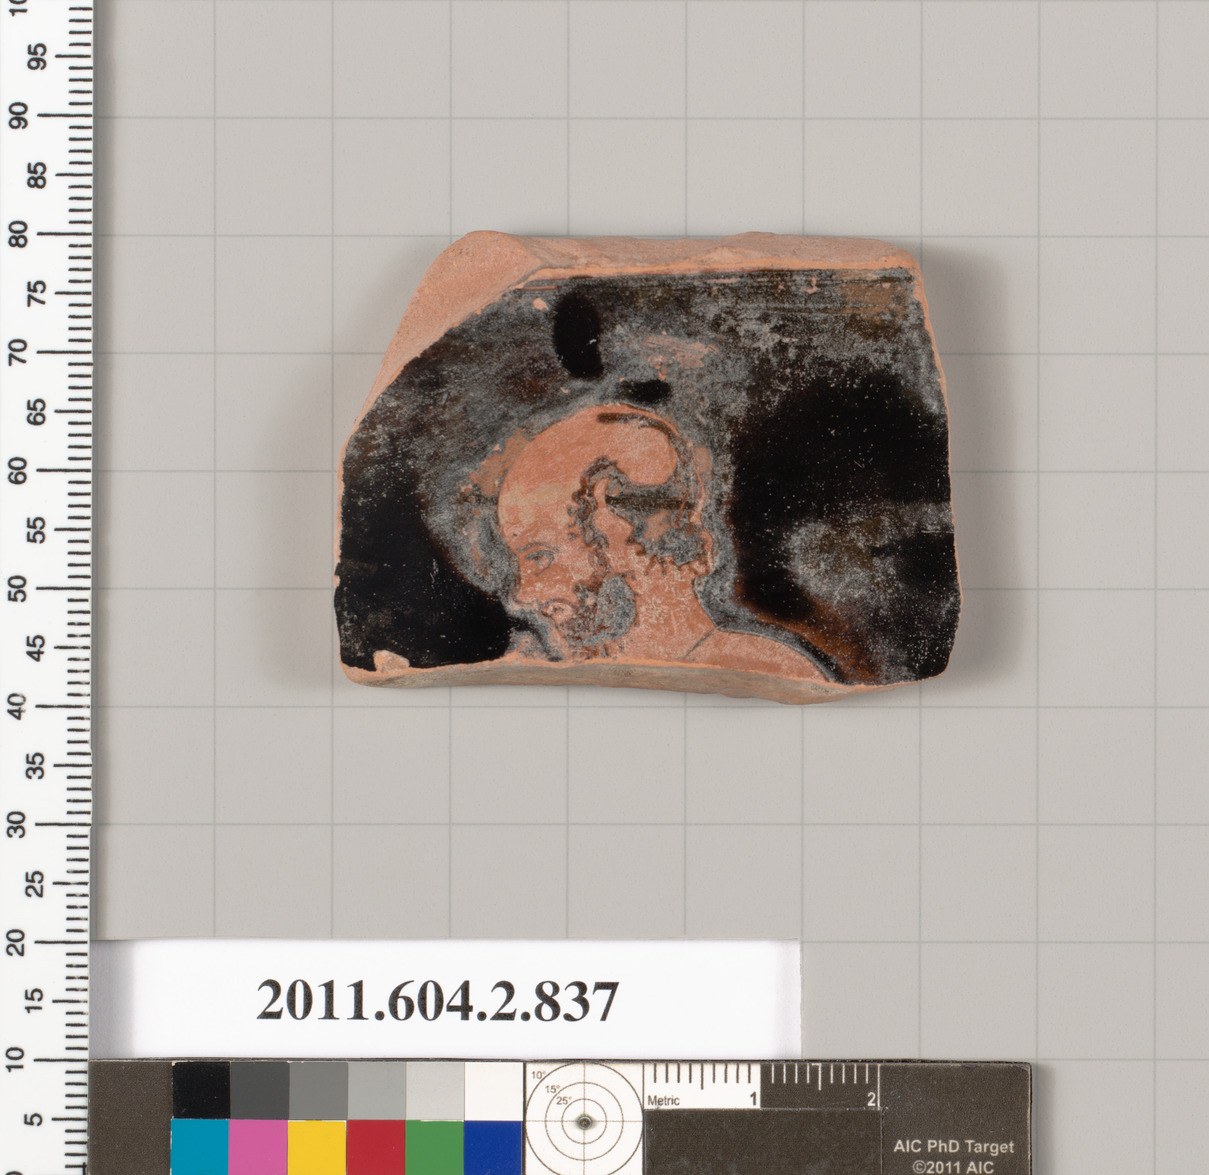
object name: bell krater fragment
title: Terracotta fragment of a bell-krater (bowl for mixing wine and water)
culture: greek, attic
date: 450-440 BCE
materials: terracotta